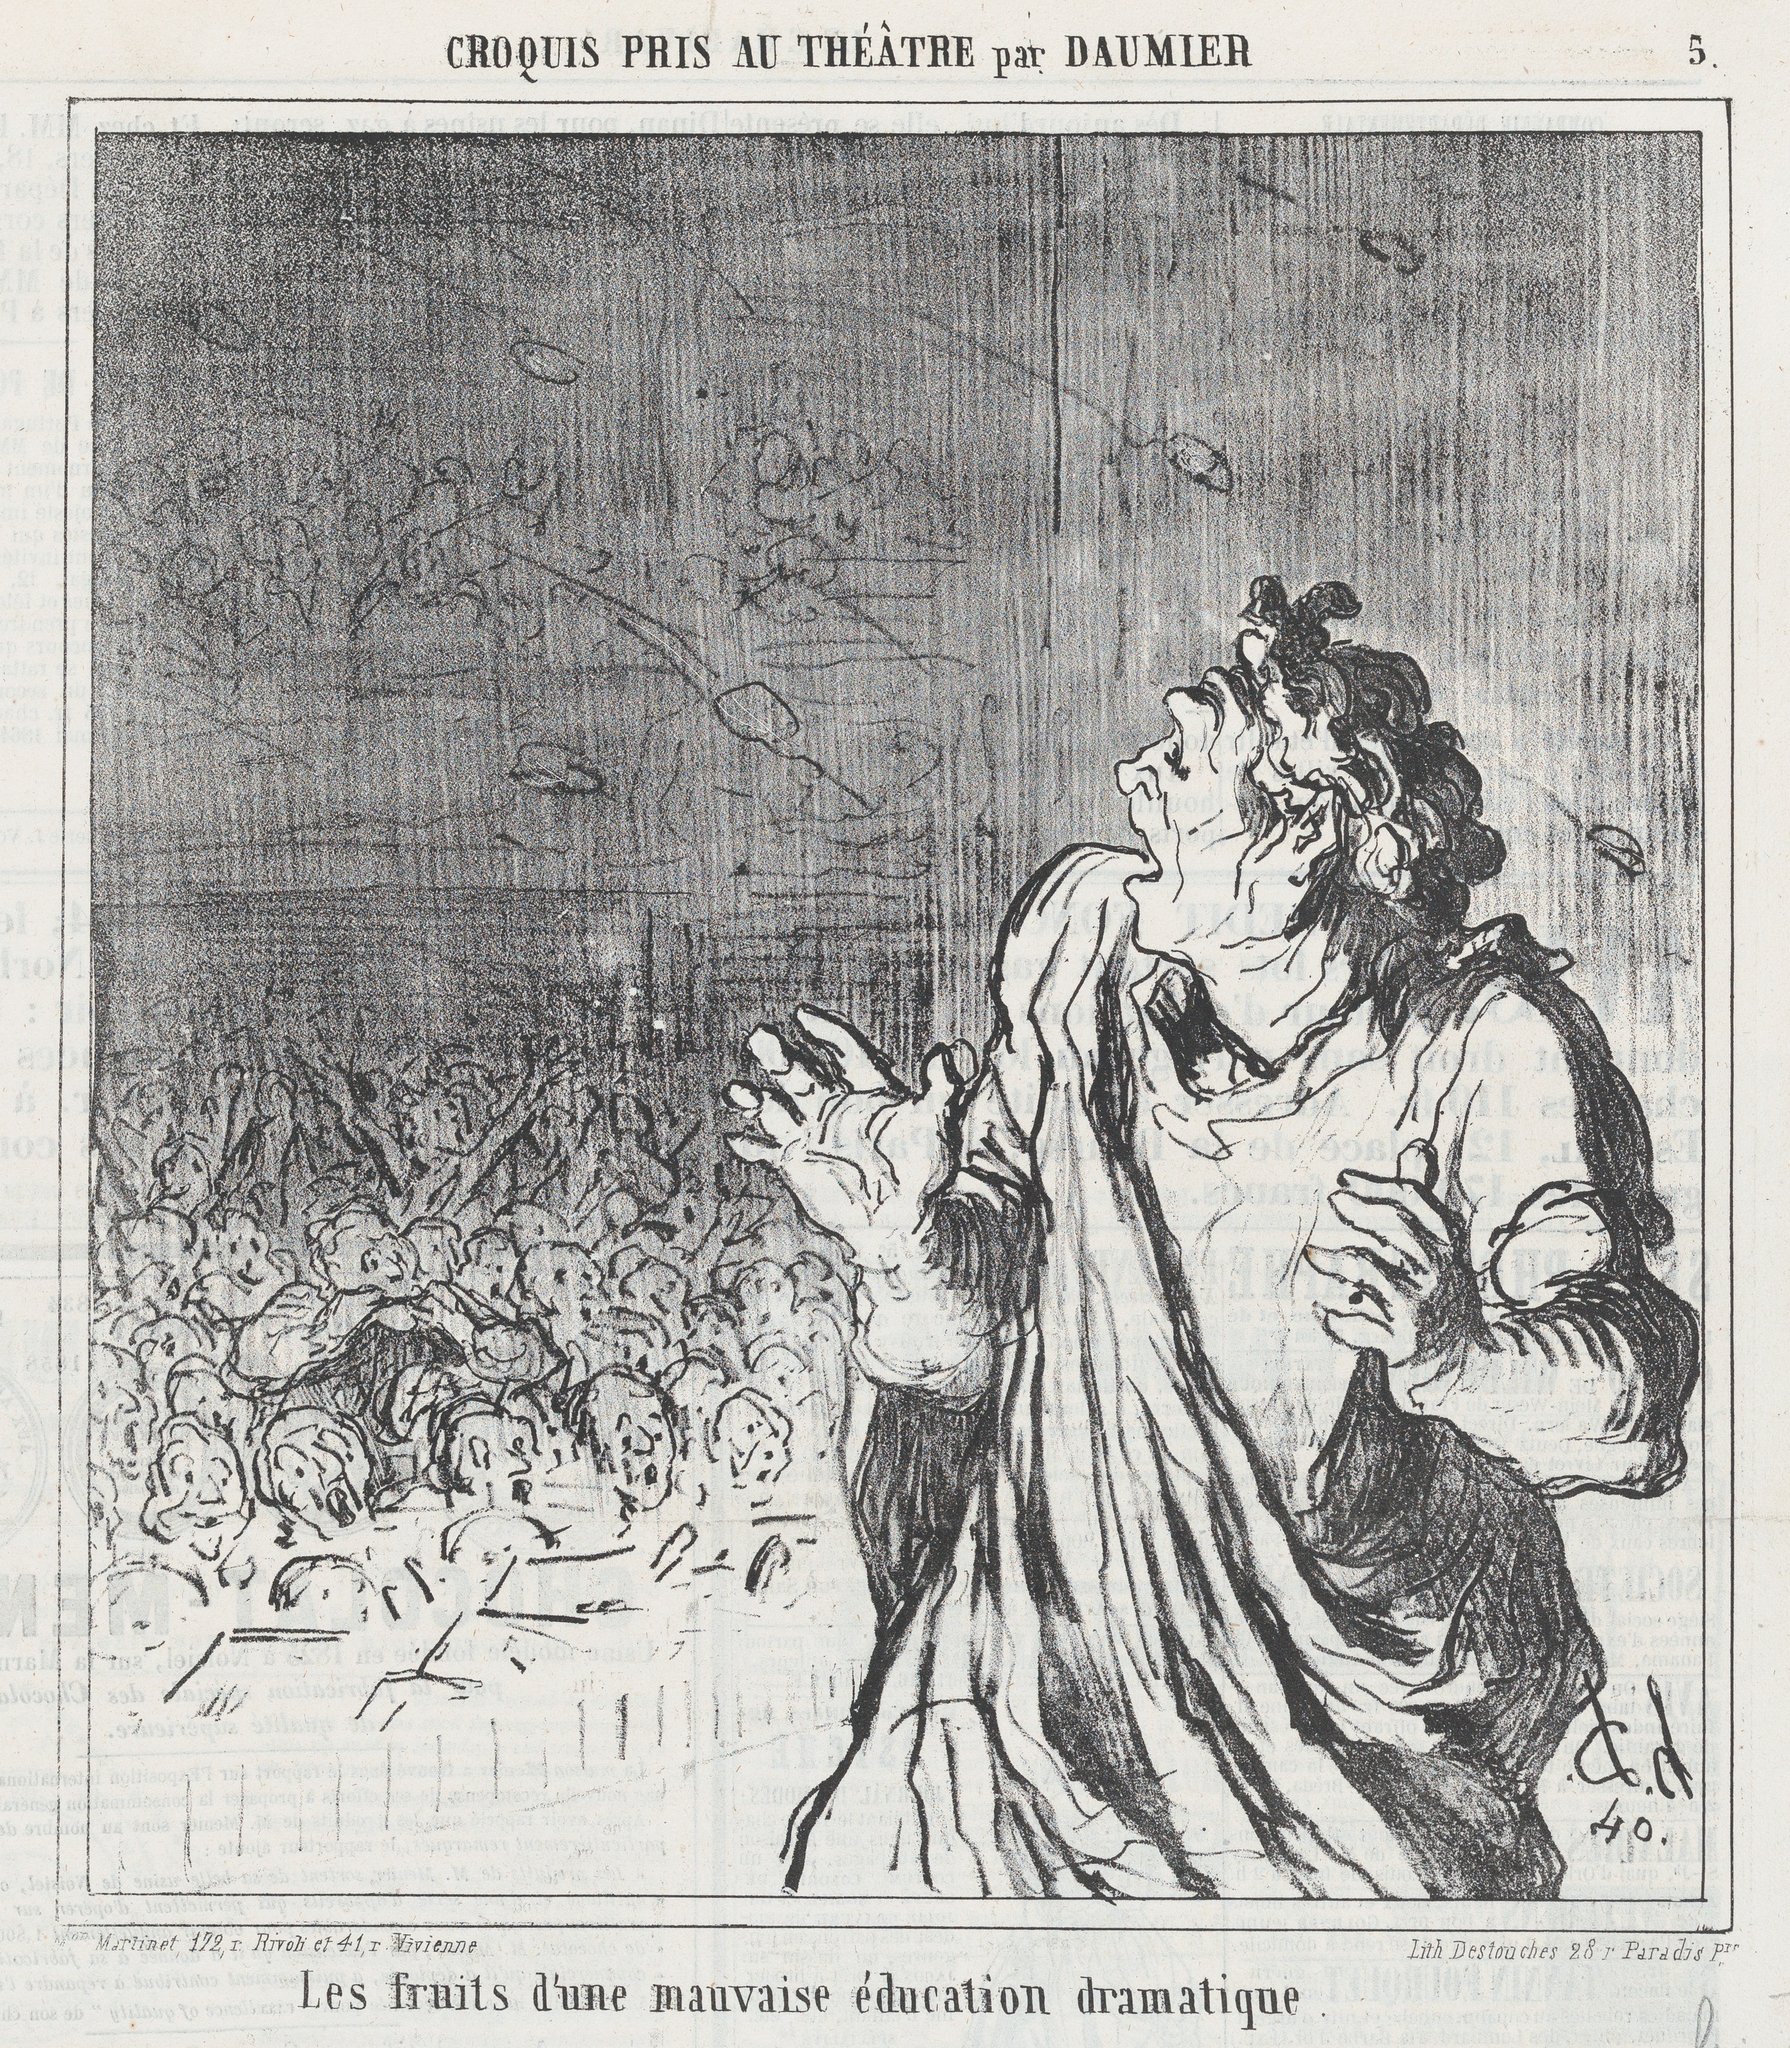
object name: print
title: The results of bad dramatic timing, from 'Theater sketches,' published in Le Charivari, 1864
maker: honoré daumier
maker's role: artist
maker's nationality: french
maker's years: 1808-1879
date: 1864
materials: paper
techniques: lithograph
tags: performance,satire,theatre,spectators